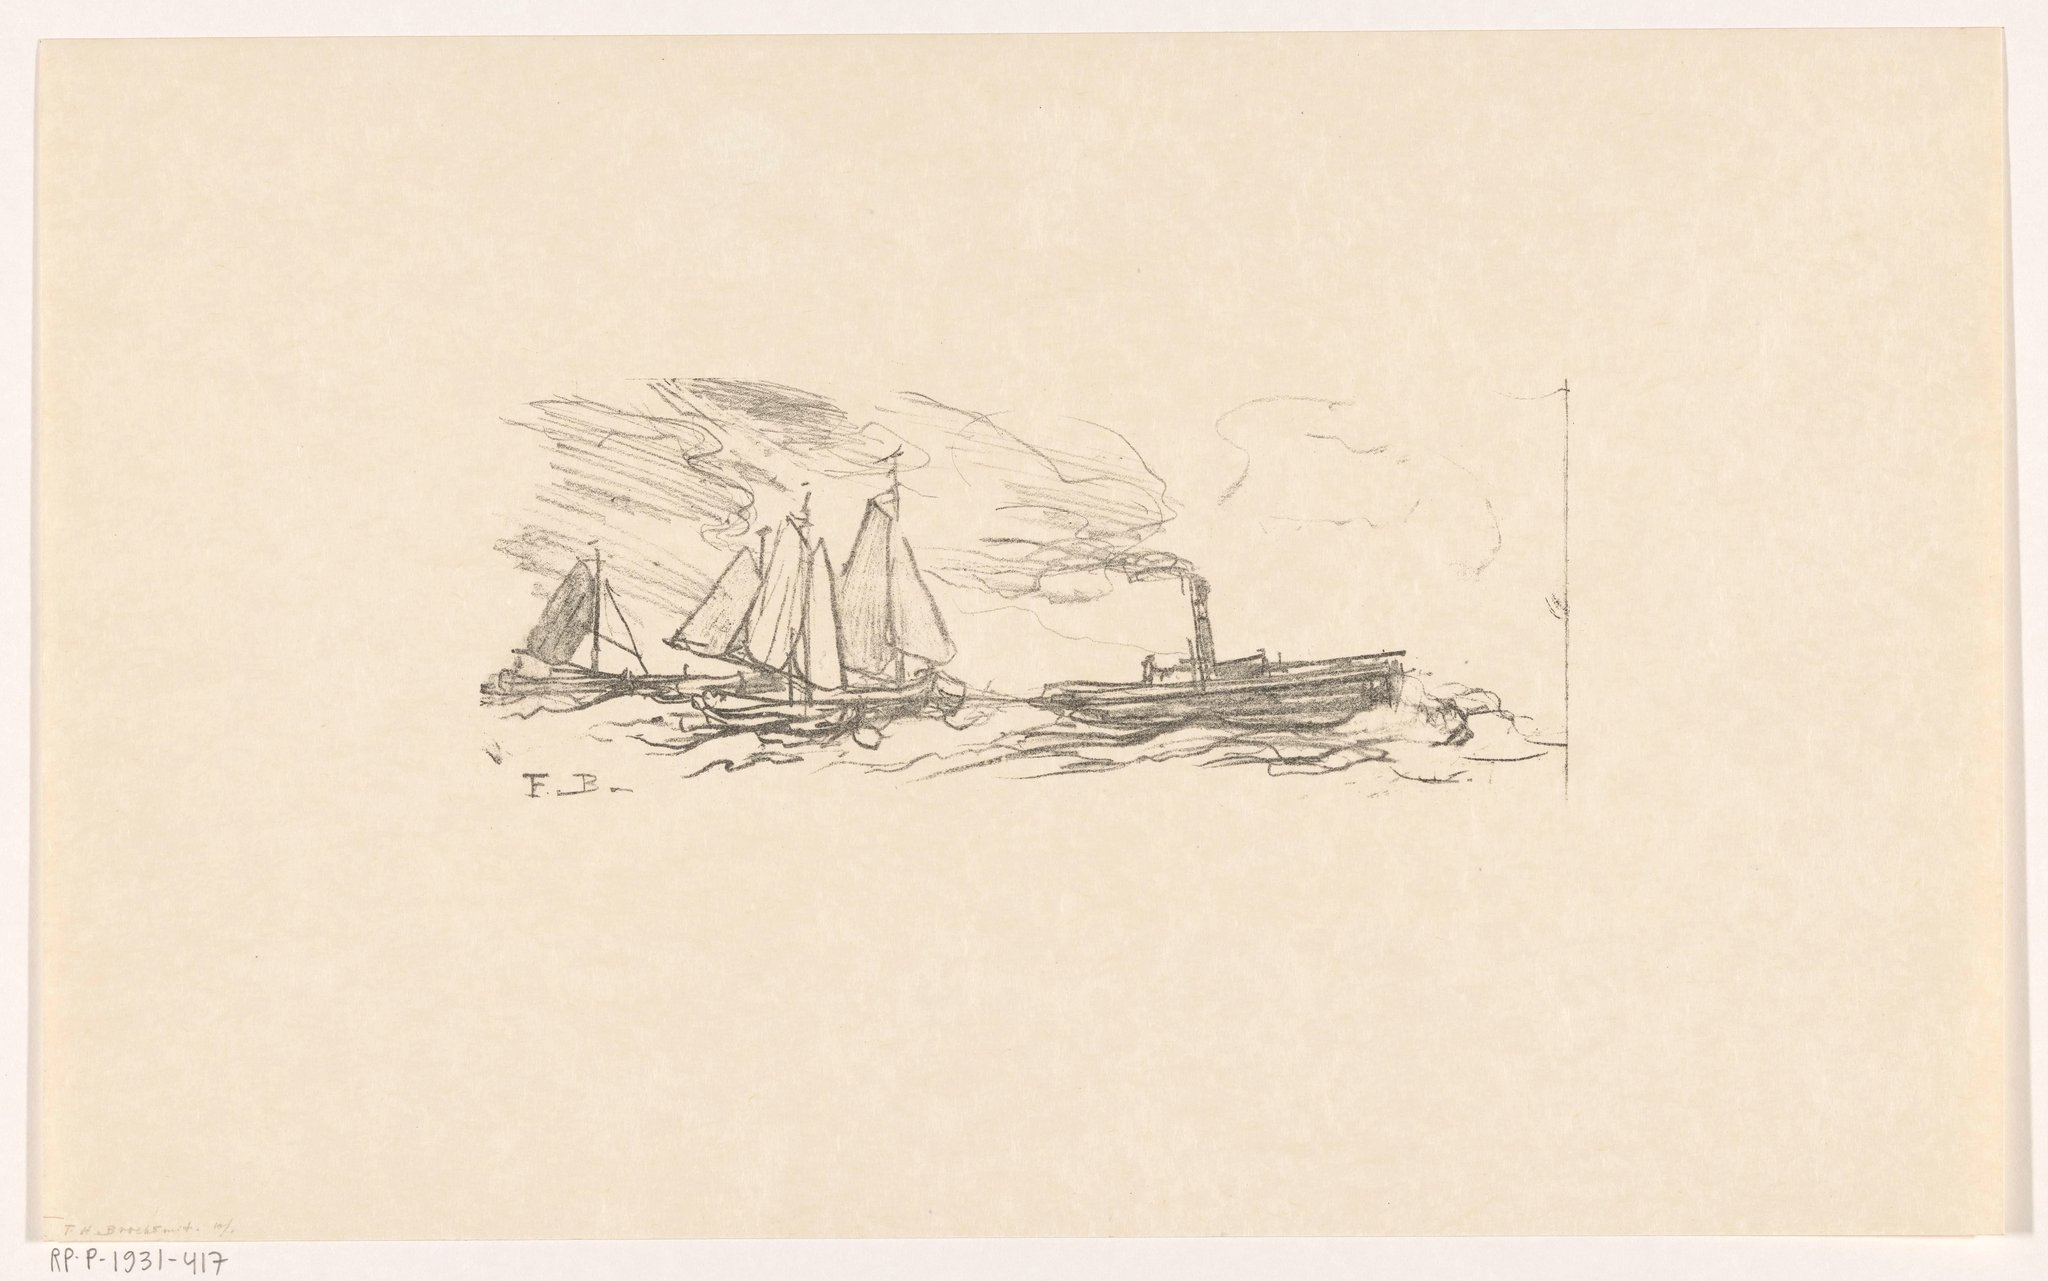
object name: print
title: Sleepboot op de Maas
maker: frederika henriëtte broeksmit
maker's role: draughtsman, print maker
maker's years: 1875-1945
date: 1885-1931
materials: paper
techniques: lithograph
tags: sailing-ship, sailing-boat, tow-boat, towing-barge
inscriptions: collector's mark: Lugt 2228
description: Een sleepboot sleept een zeilschip voort.